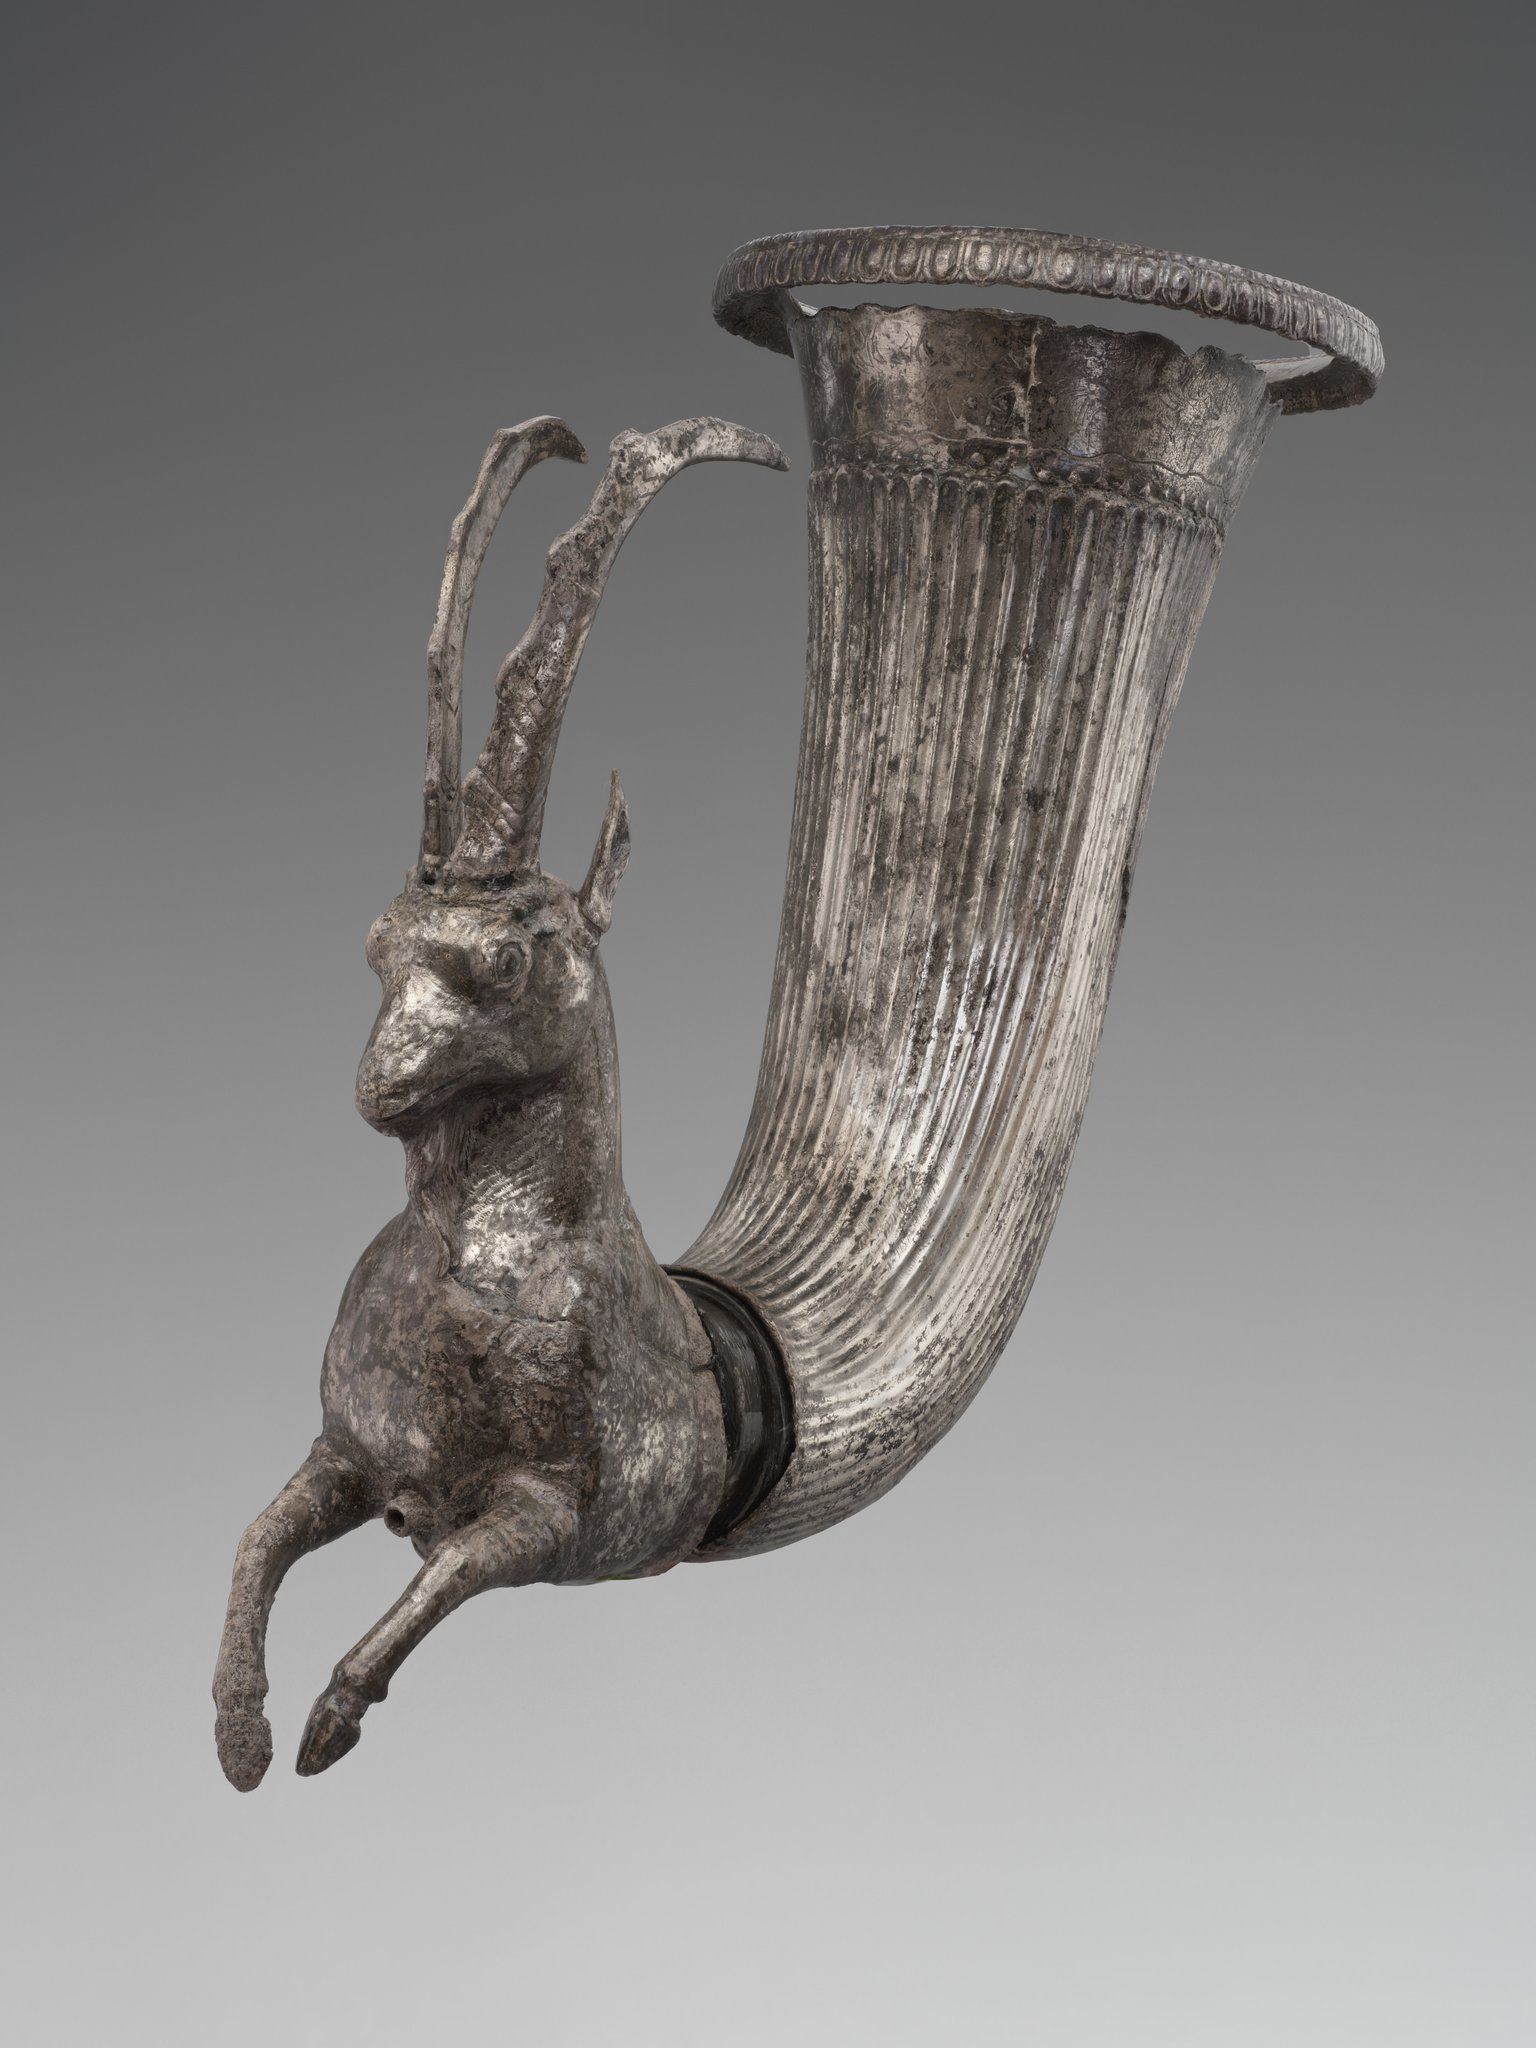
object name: rhyton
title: Rhyton terminating in the forepart of a wild goat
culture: thracian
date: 400-301 BCE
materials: silver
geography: iran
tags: goats